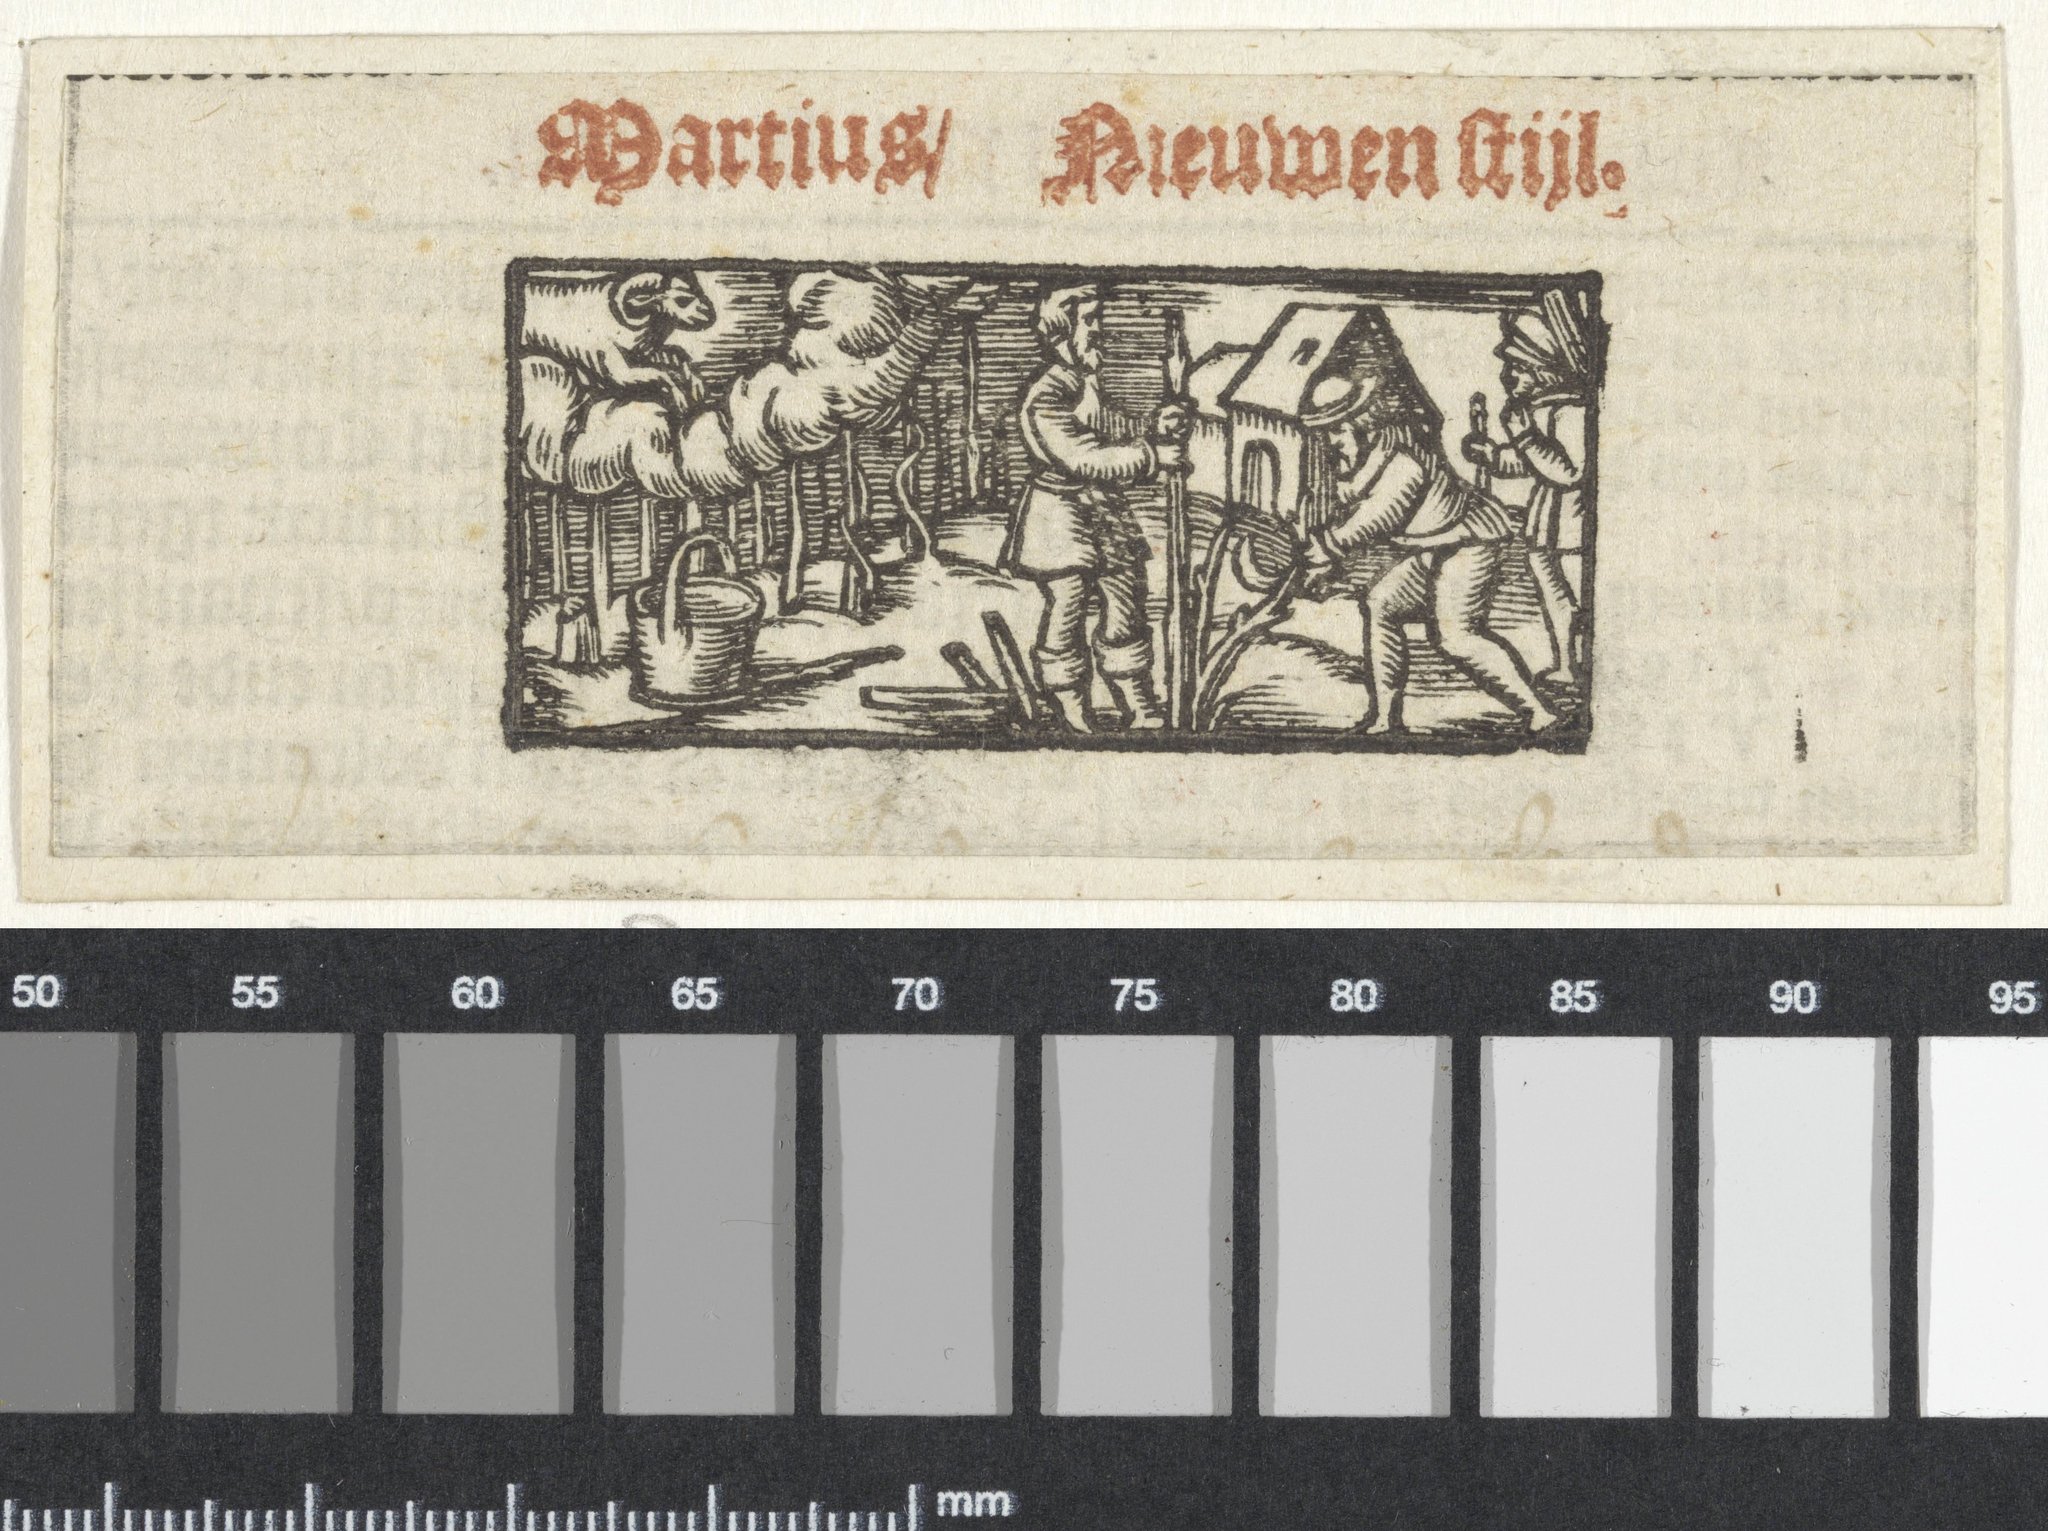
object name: print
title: Maanden van het jaar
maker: Anonymous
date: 1600-1699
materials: paper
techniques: letterpress printing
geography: netherlands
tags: march and its 'labours' (+ with aries (march)), orchard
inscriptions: collector's mark: Lugt 240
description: Drie mannen werkend bij een boomgaard. Linksboven een ram.